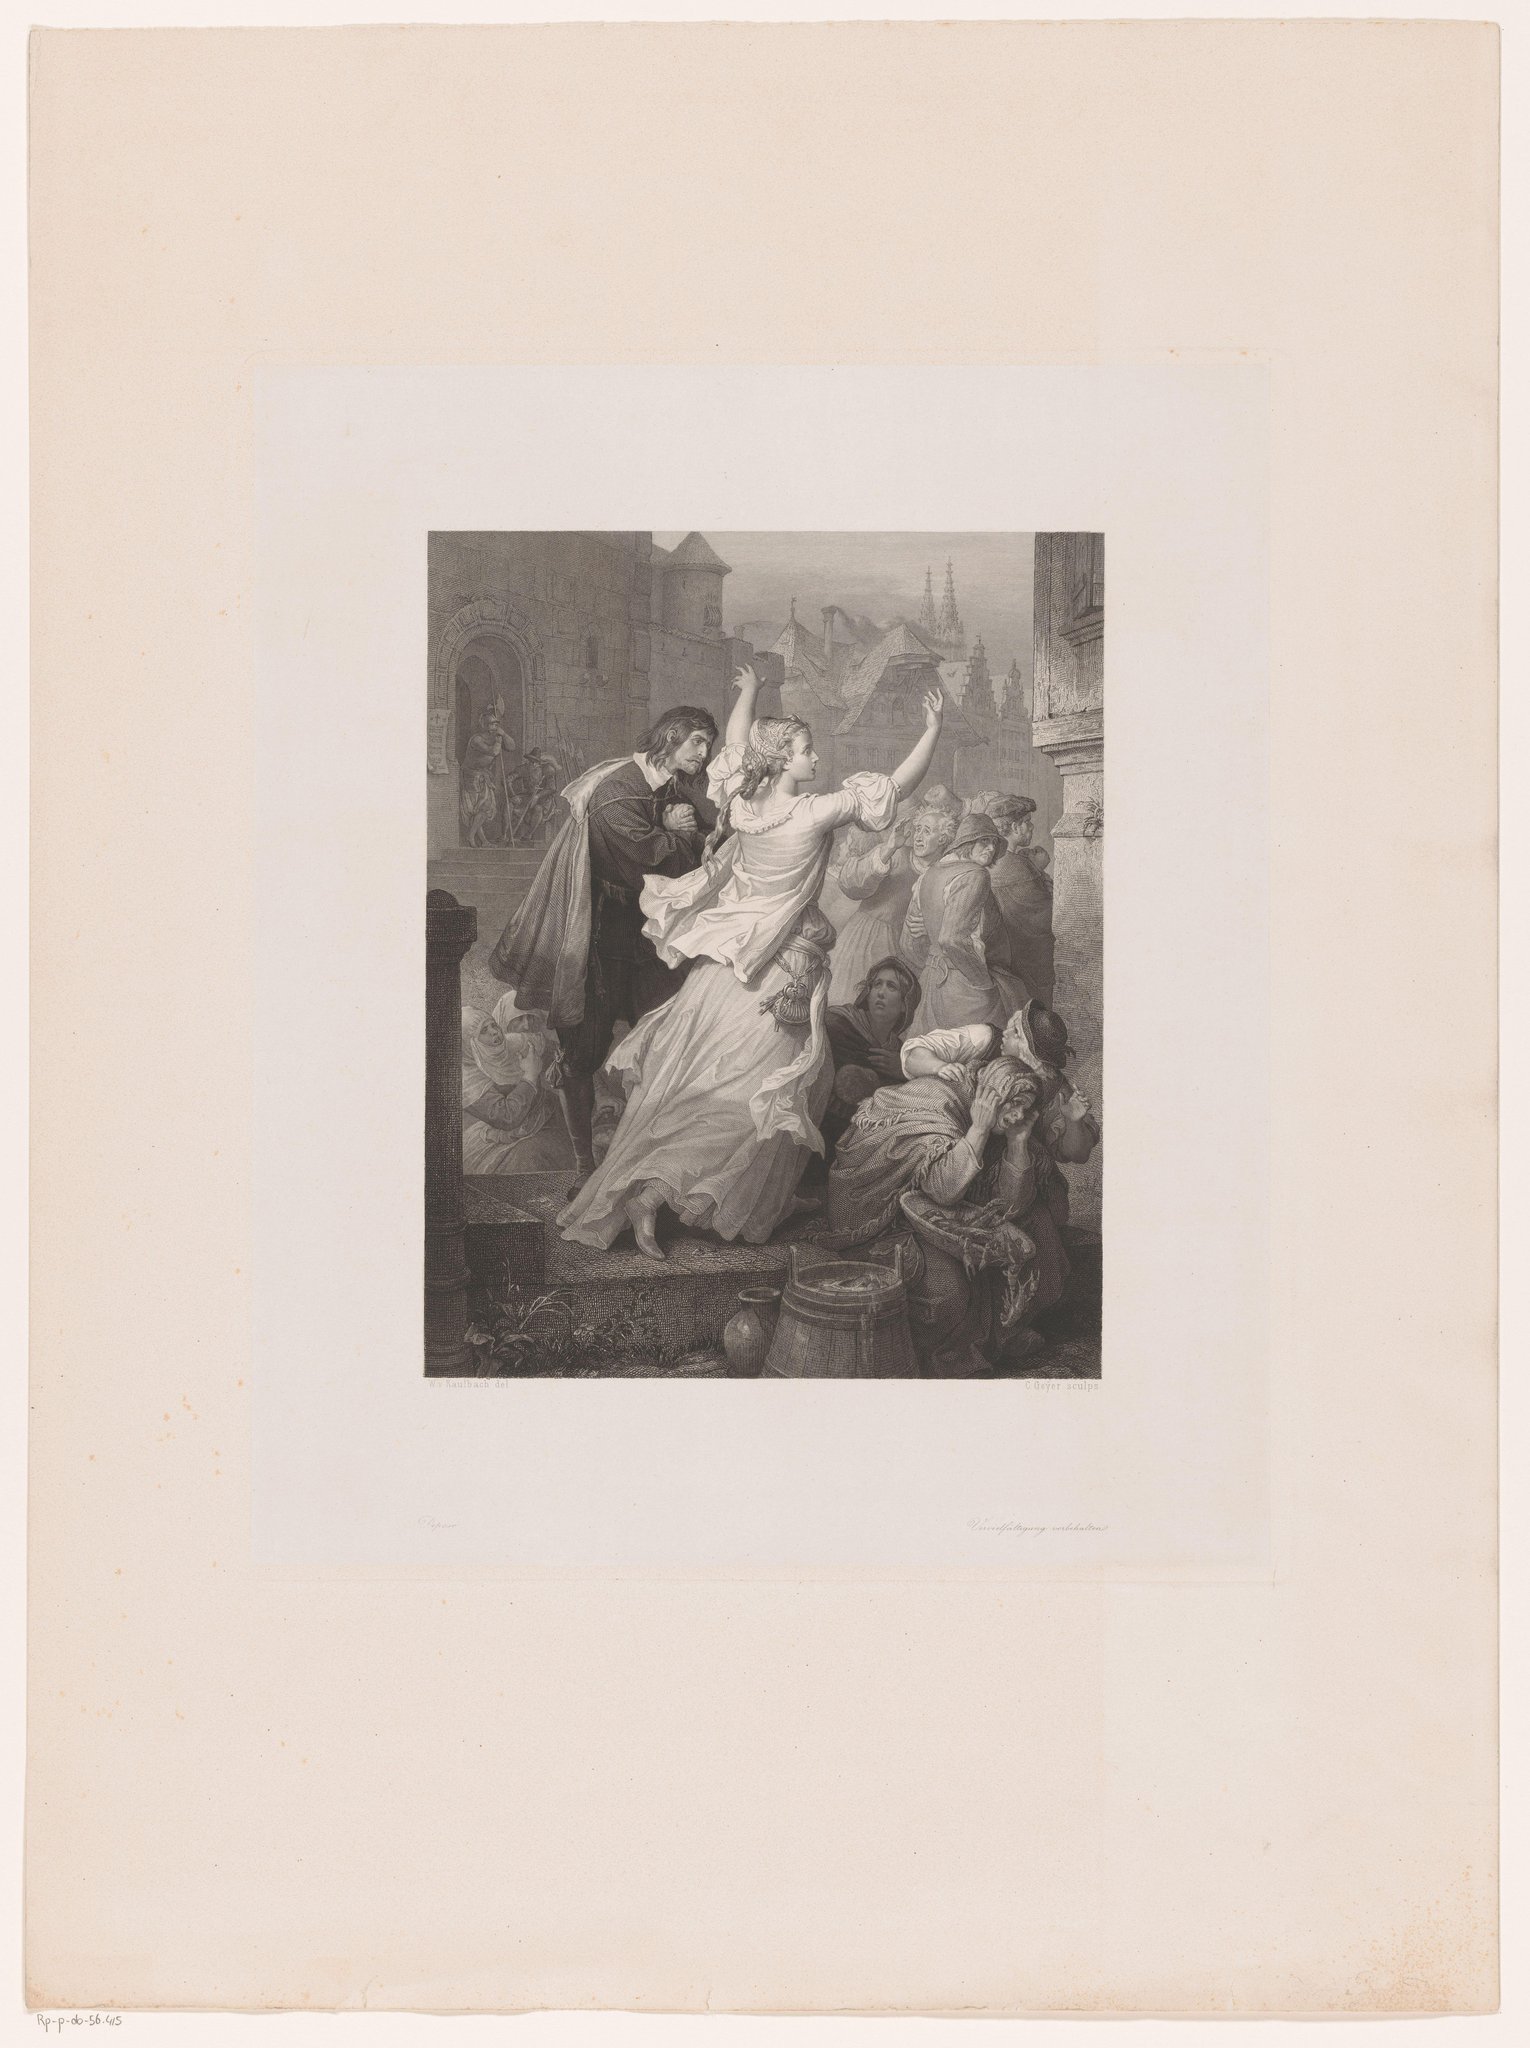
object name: print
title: Clärchen uit Goethe's Egmont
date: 1826-1893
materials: paper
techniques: engraving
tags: confusion, bewilderment, panic; 'perturbatione' (ripa), village square, place, female literary characters